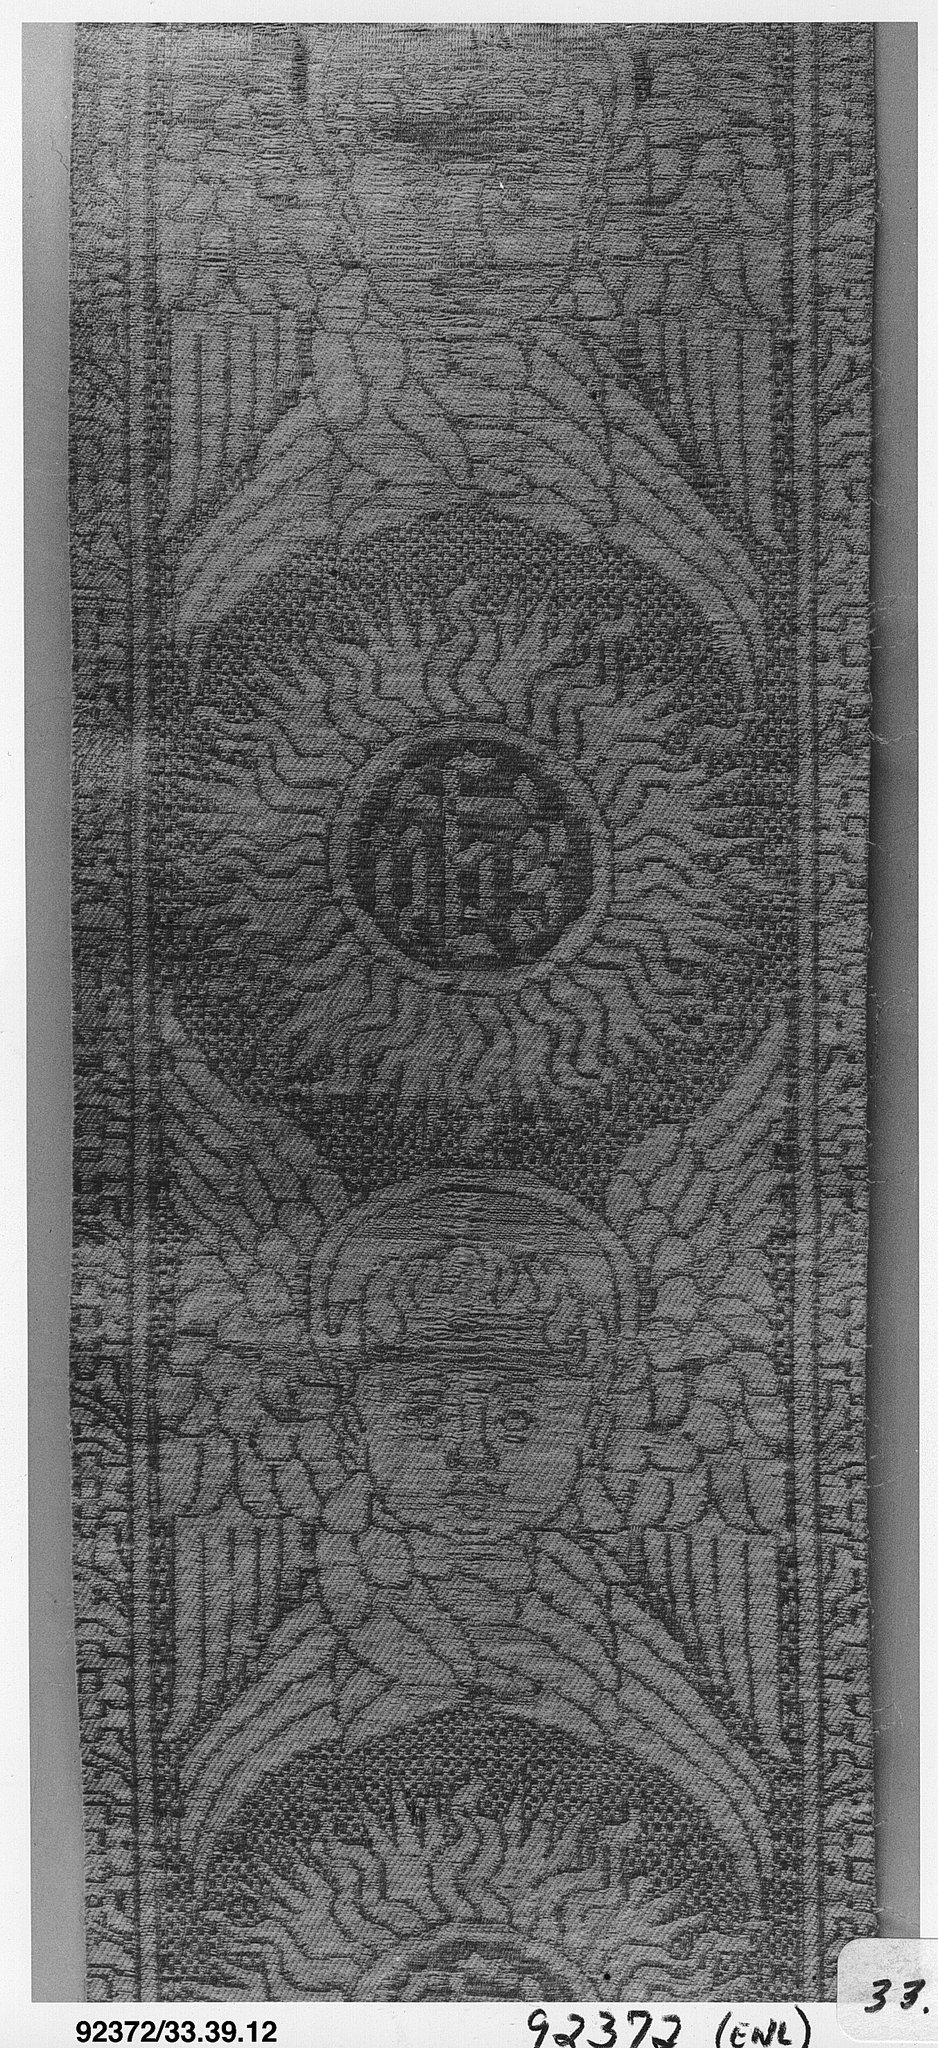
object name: orphrey fragment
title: Orphrey woven with figurative repeat design of seraphim with IHS Christogram in glories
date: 1401-1600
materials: linen, silk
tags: angels